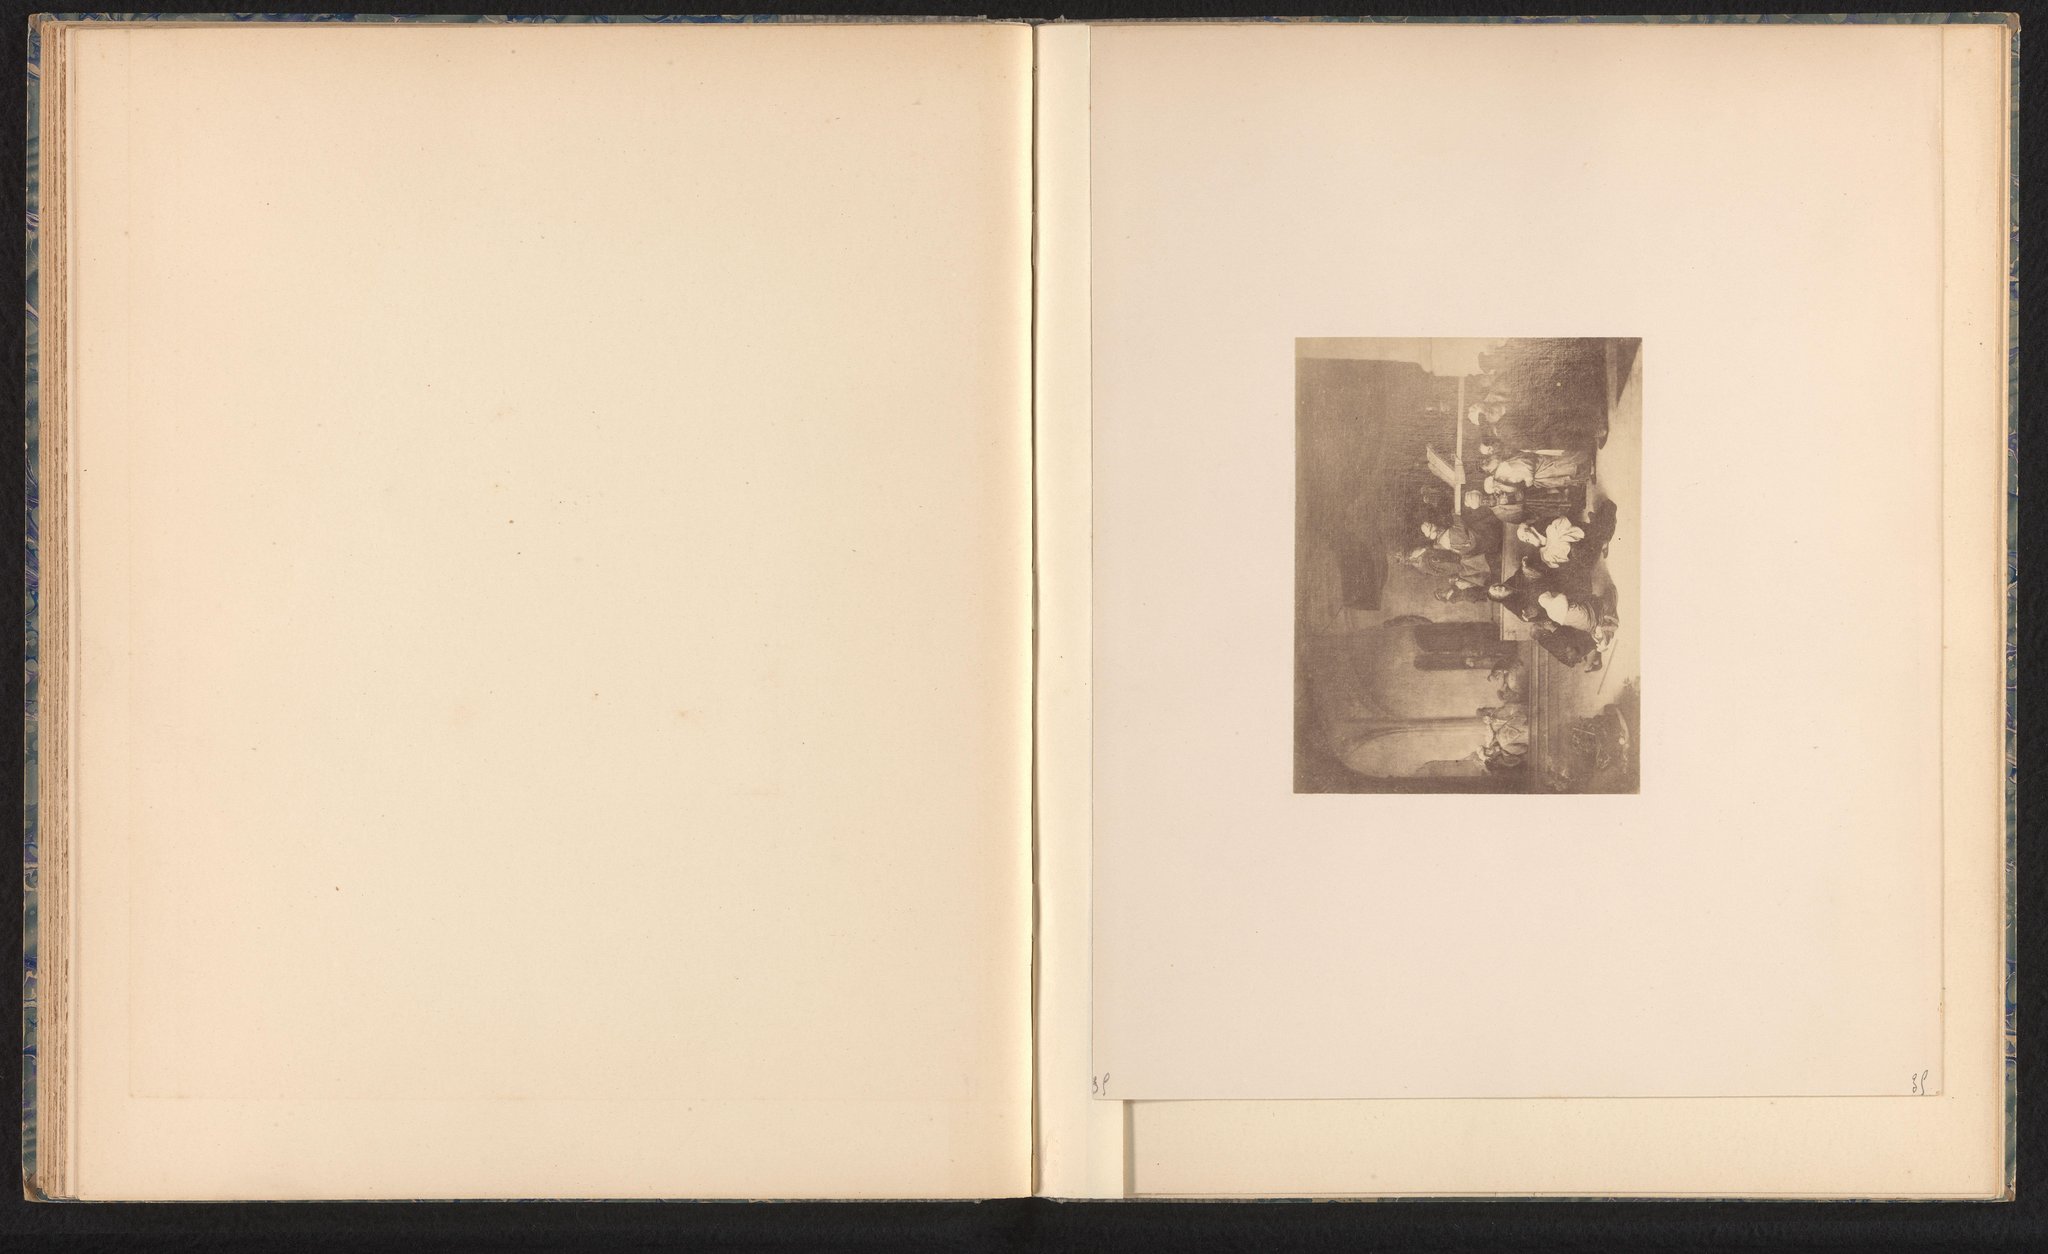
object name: reproduction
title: Fotoreproductie van een schilderij met de presentatie van Christus in de tempel door Christian Wilhelm Ernst Dietrich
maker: Anonymous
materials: paper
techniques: albumen print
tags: presentation of the christ-child in the temple, usually simeon (and anna) present (luke 2:22-39)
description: Foto op de 45e ongenummerde pagina na titelpagina.